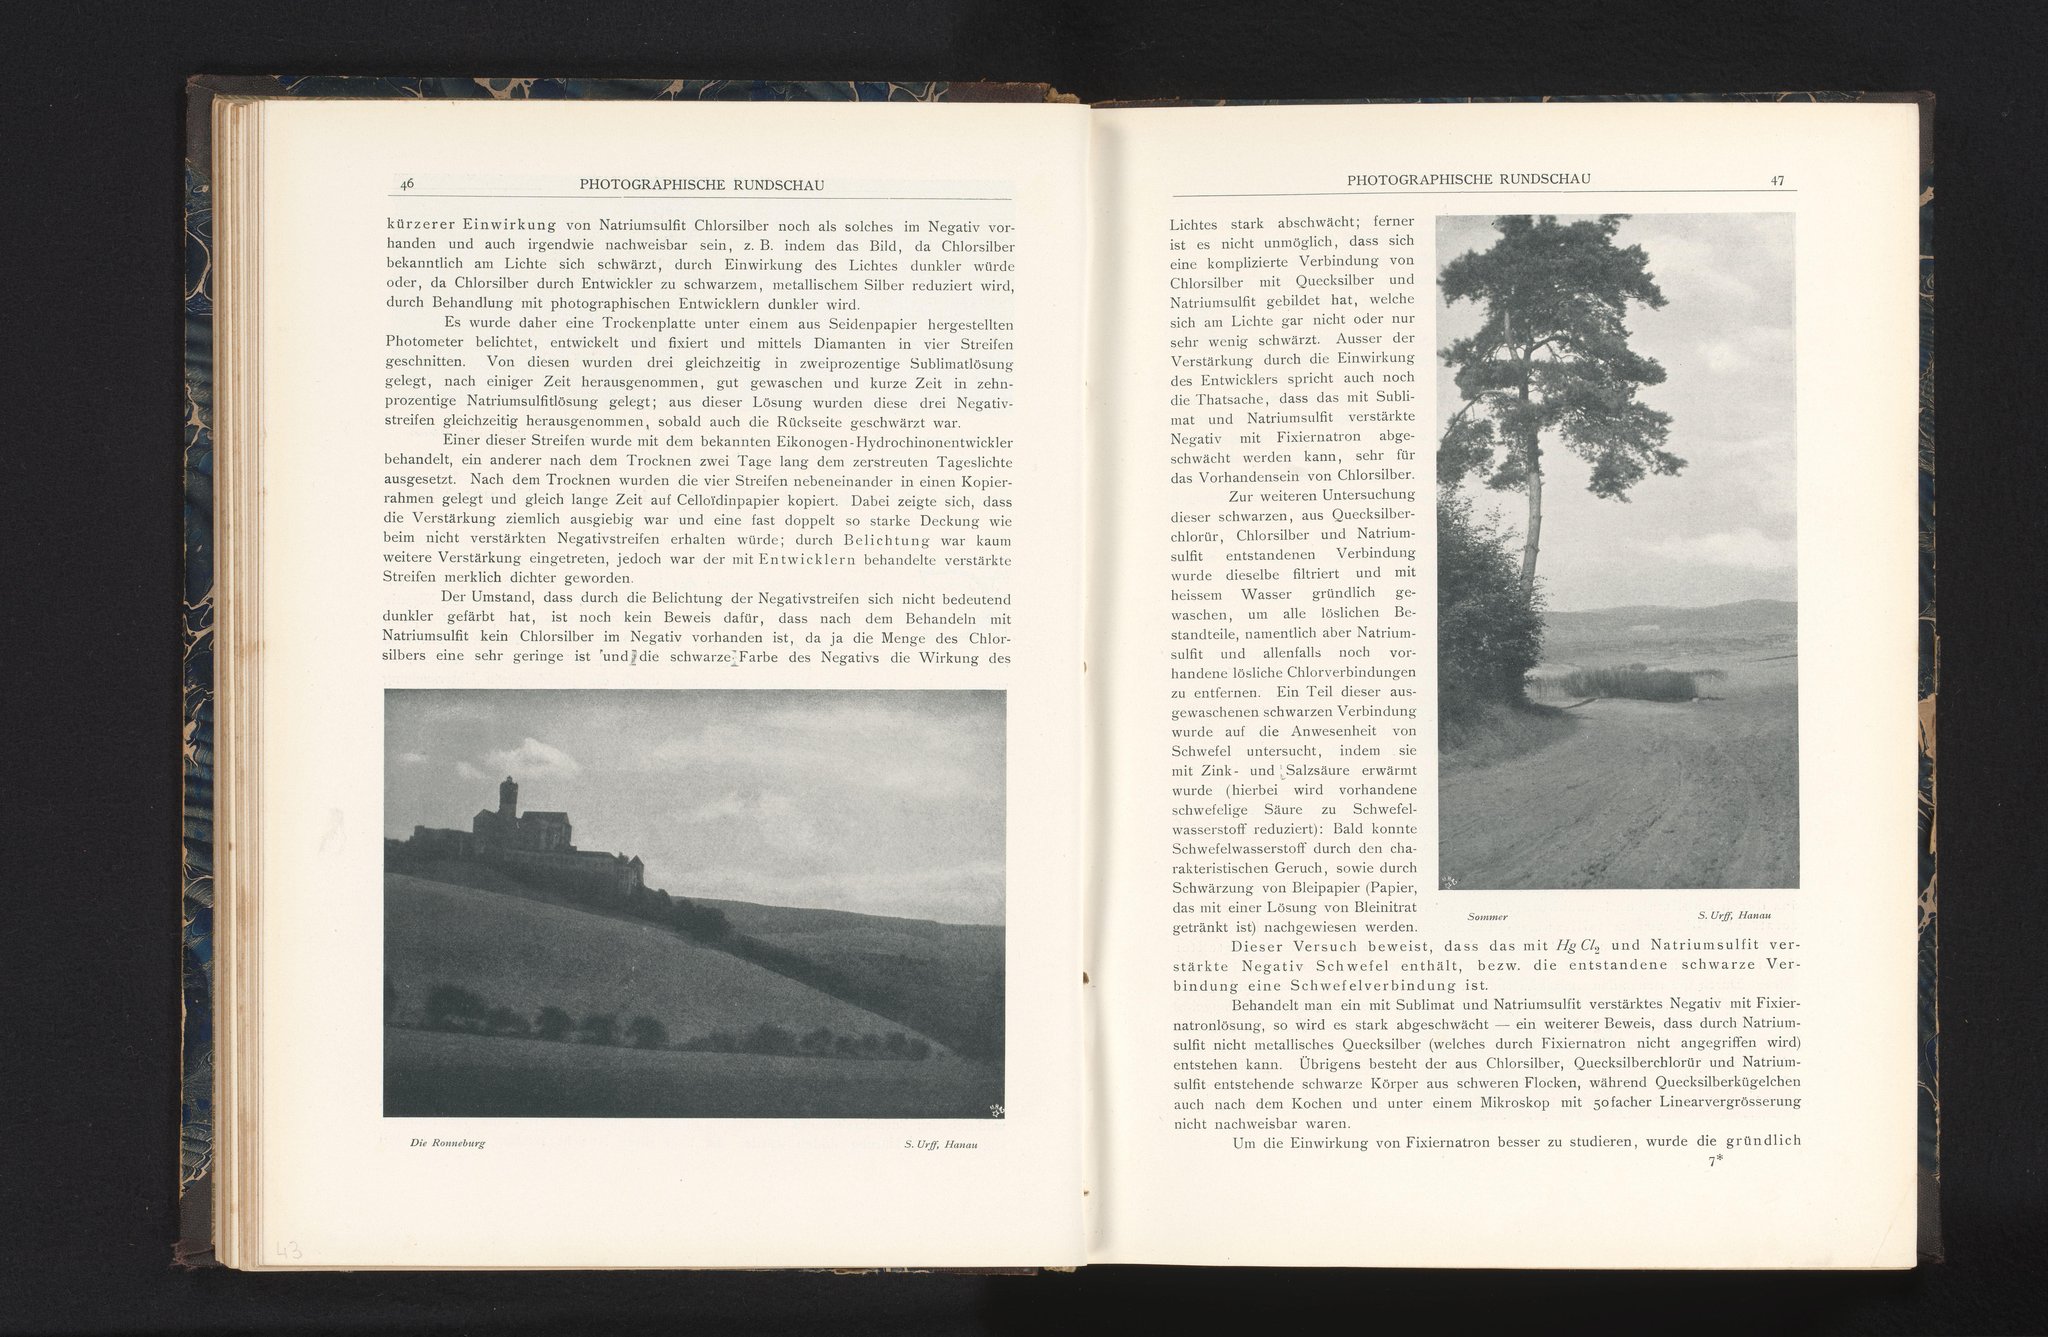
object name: photomechanical print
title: Die Ronneburg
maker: s. urff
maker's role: fotograaf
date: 1897-1902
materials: paper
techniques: autotype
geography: ronneburg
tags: castle, (high) hill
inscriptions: monogram: ‘MR&C’